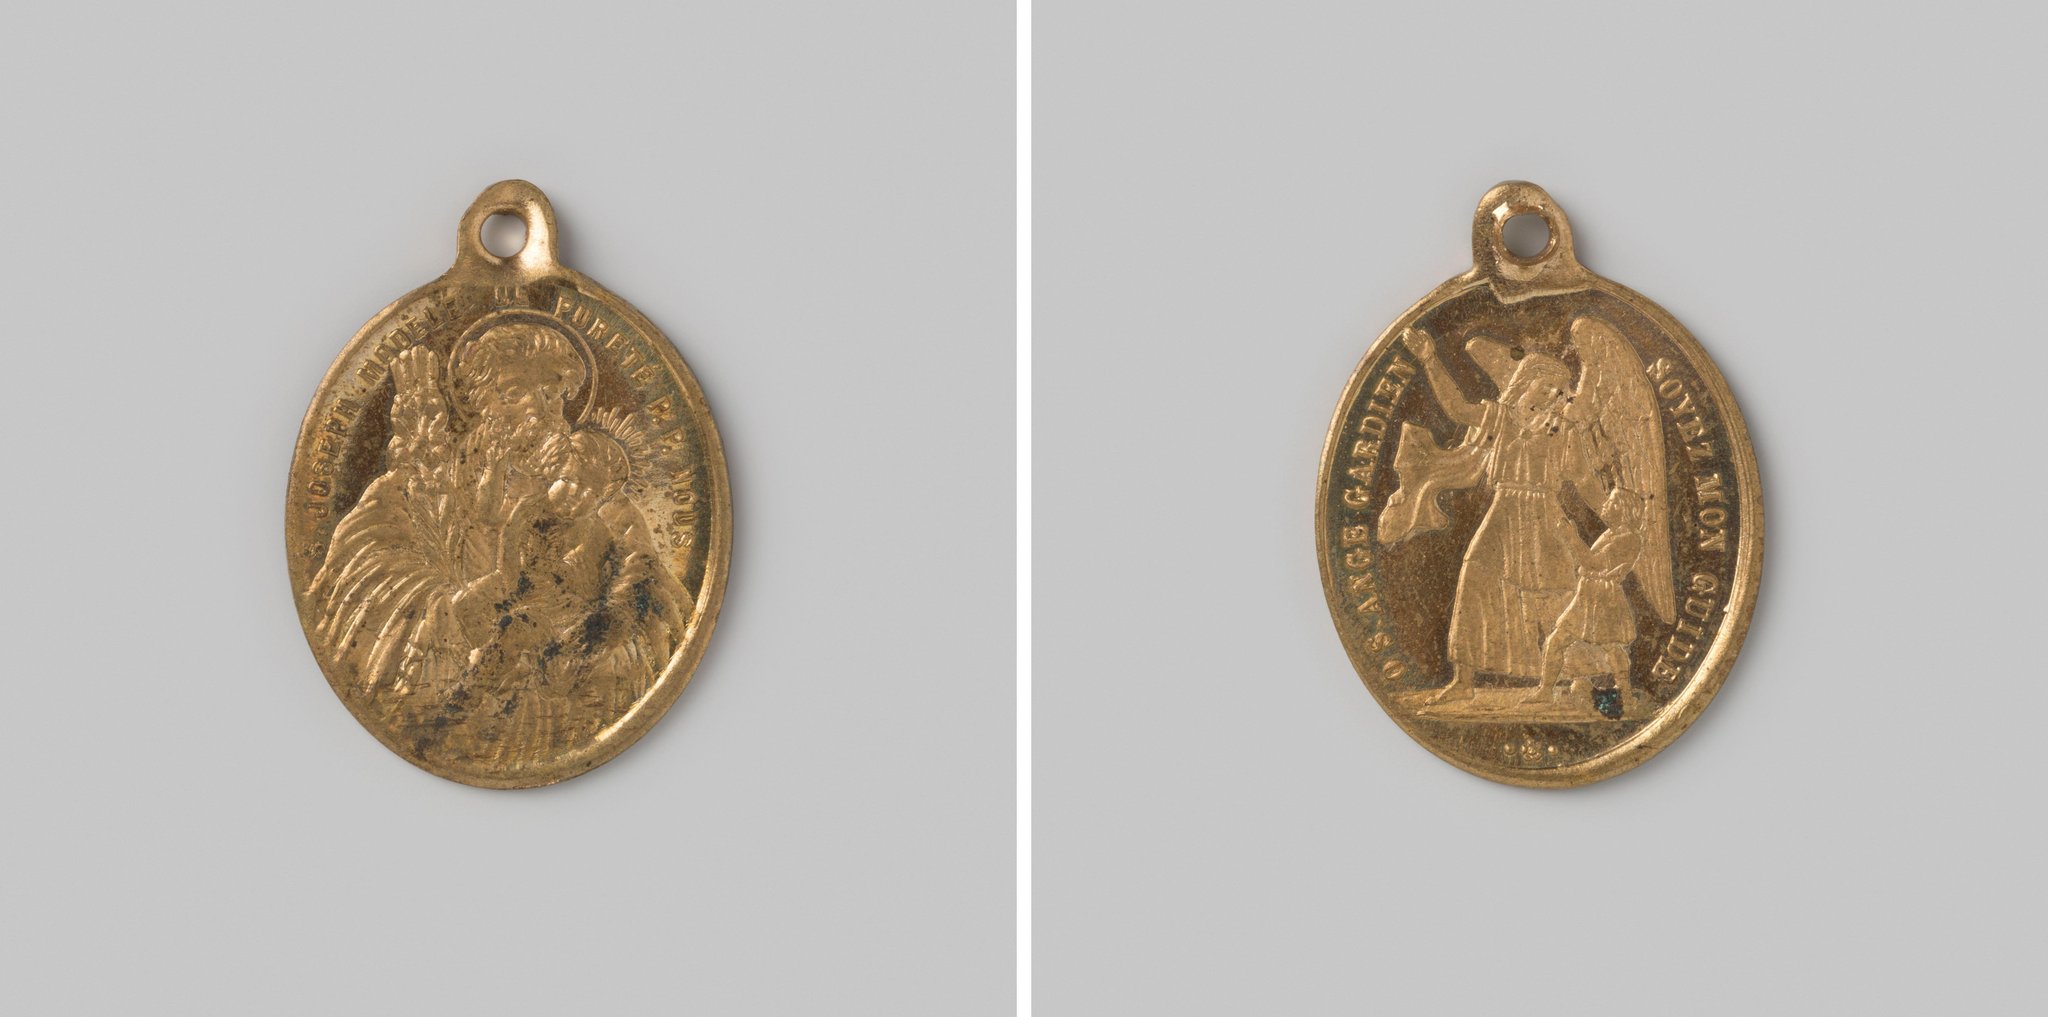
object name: history medal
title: Religieus draagteken met St Jozef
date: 1750-1850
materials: brass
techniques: striking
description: Ovaal messing draagteken met draagoog, op de voorzijde Josef met Kind, met omschrift, op de keerzijde een kind met beschermengel, met omschrift.